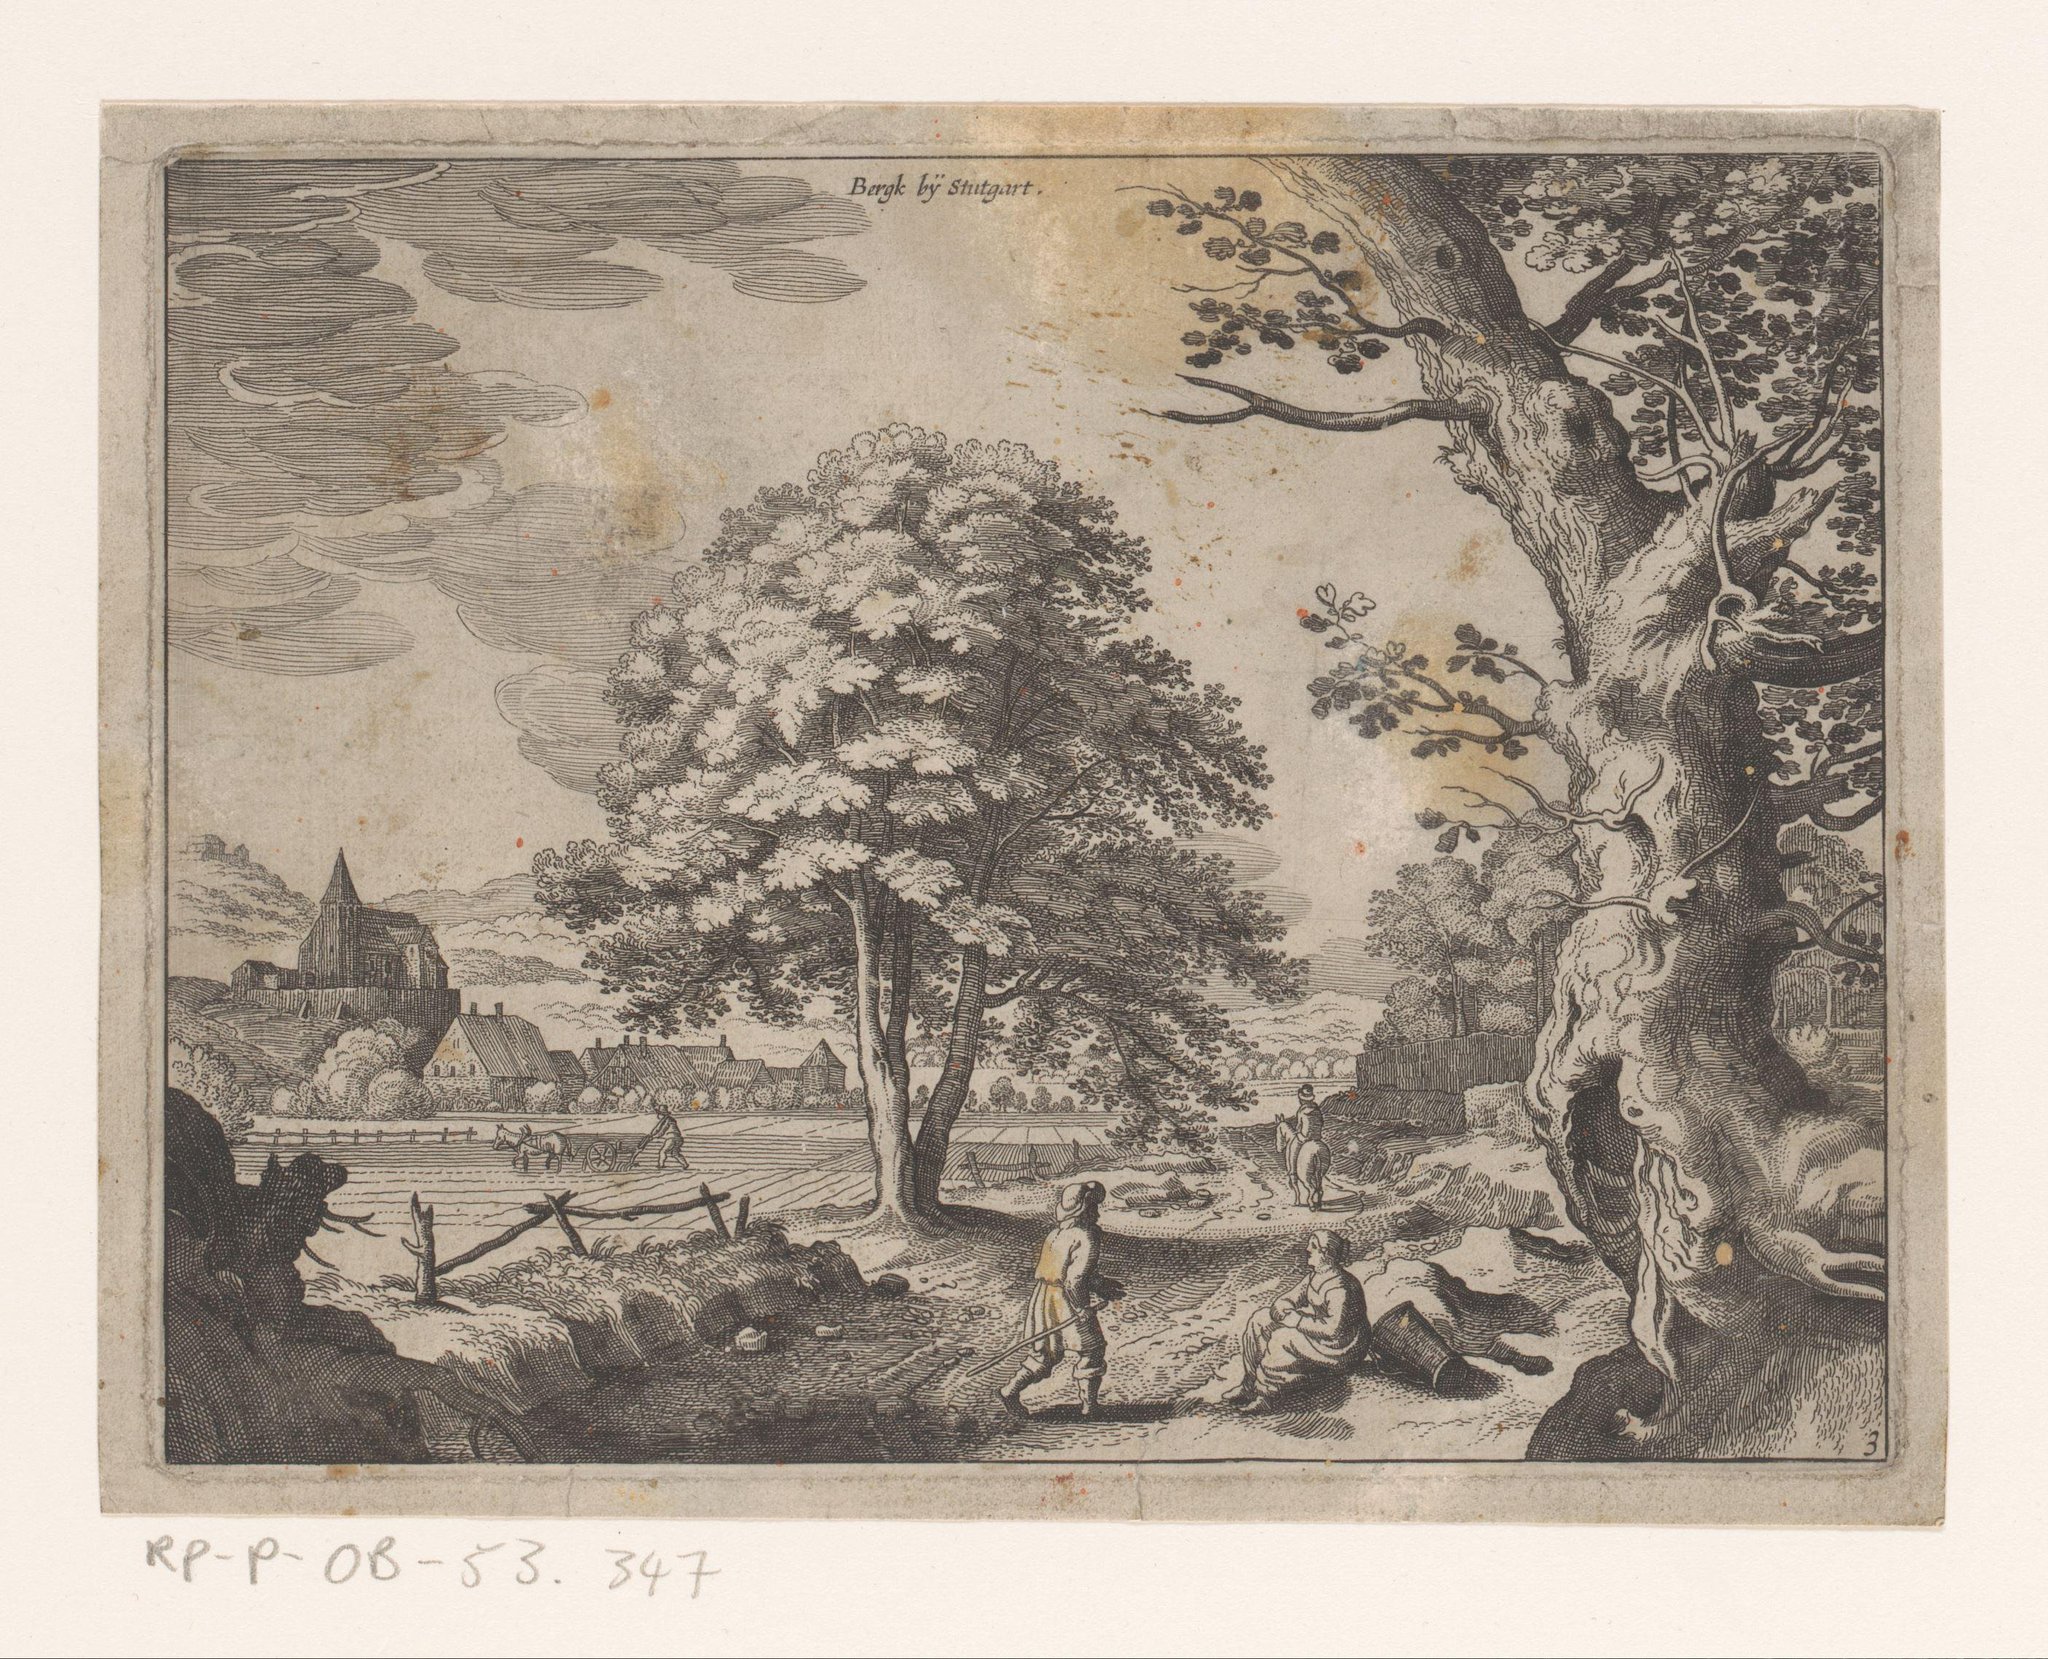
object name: print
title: Gezicht op Berg bij Stuttgart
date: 1628-1679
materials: paper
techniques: etching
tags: city-view, and landscape with man-made constructions, ploughed field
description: Kopie in dezelfde richting naar de prent van Matthäus Merian I (Hollstein 343). Deze prent heeft nummer 3 rechtsonder gedrukt.